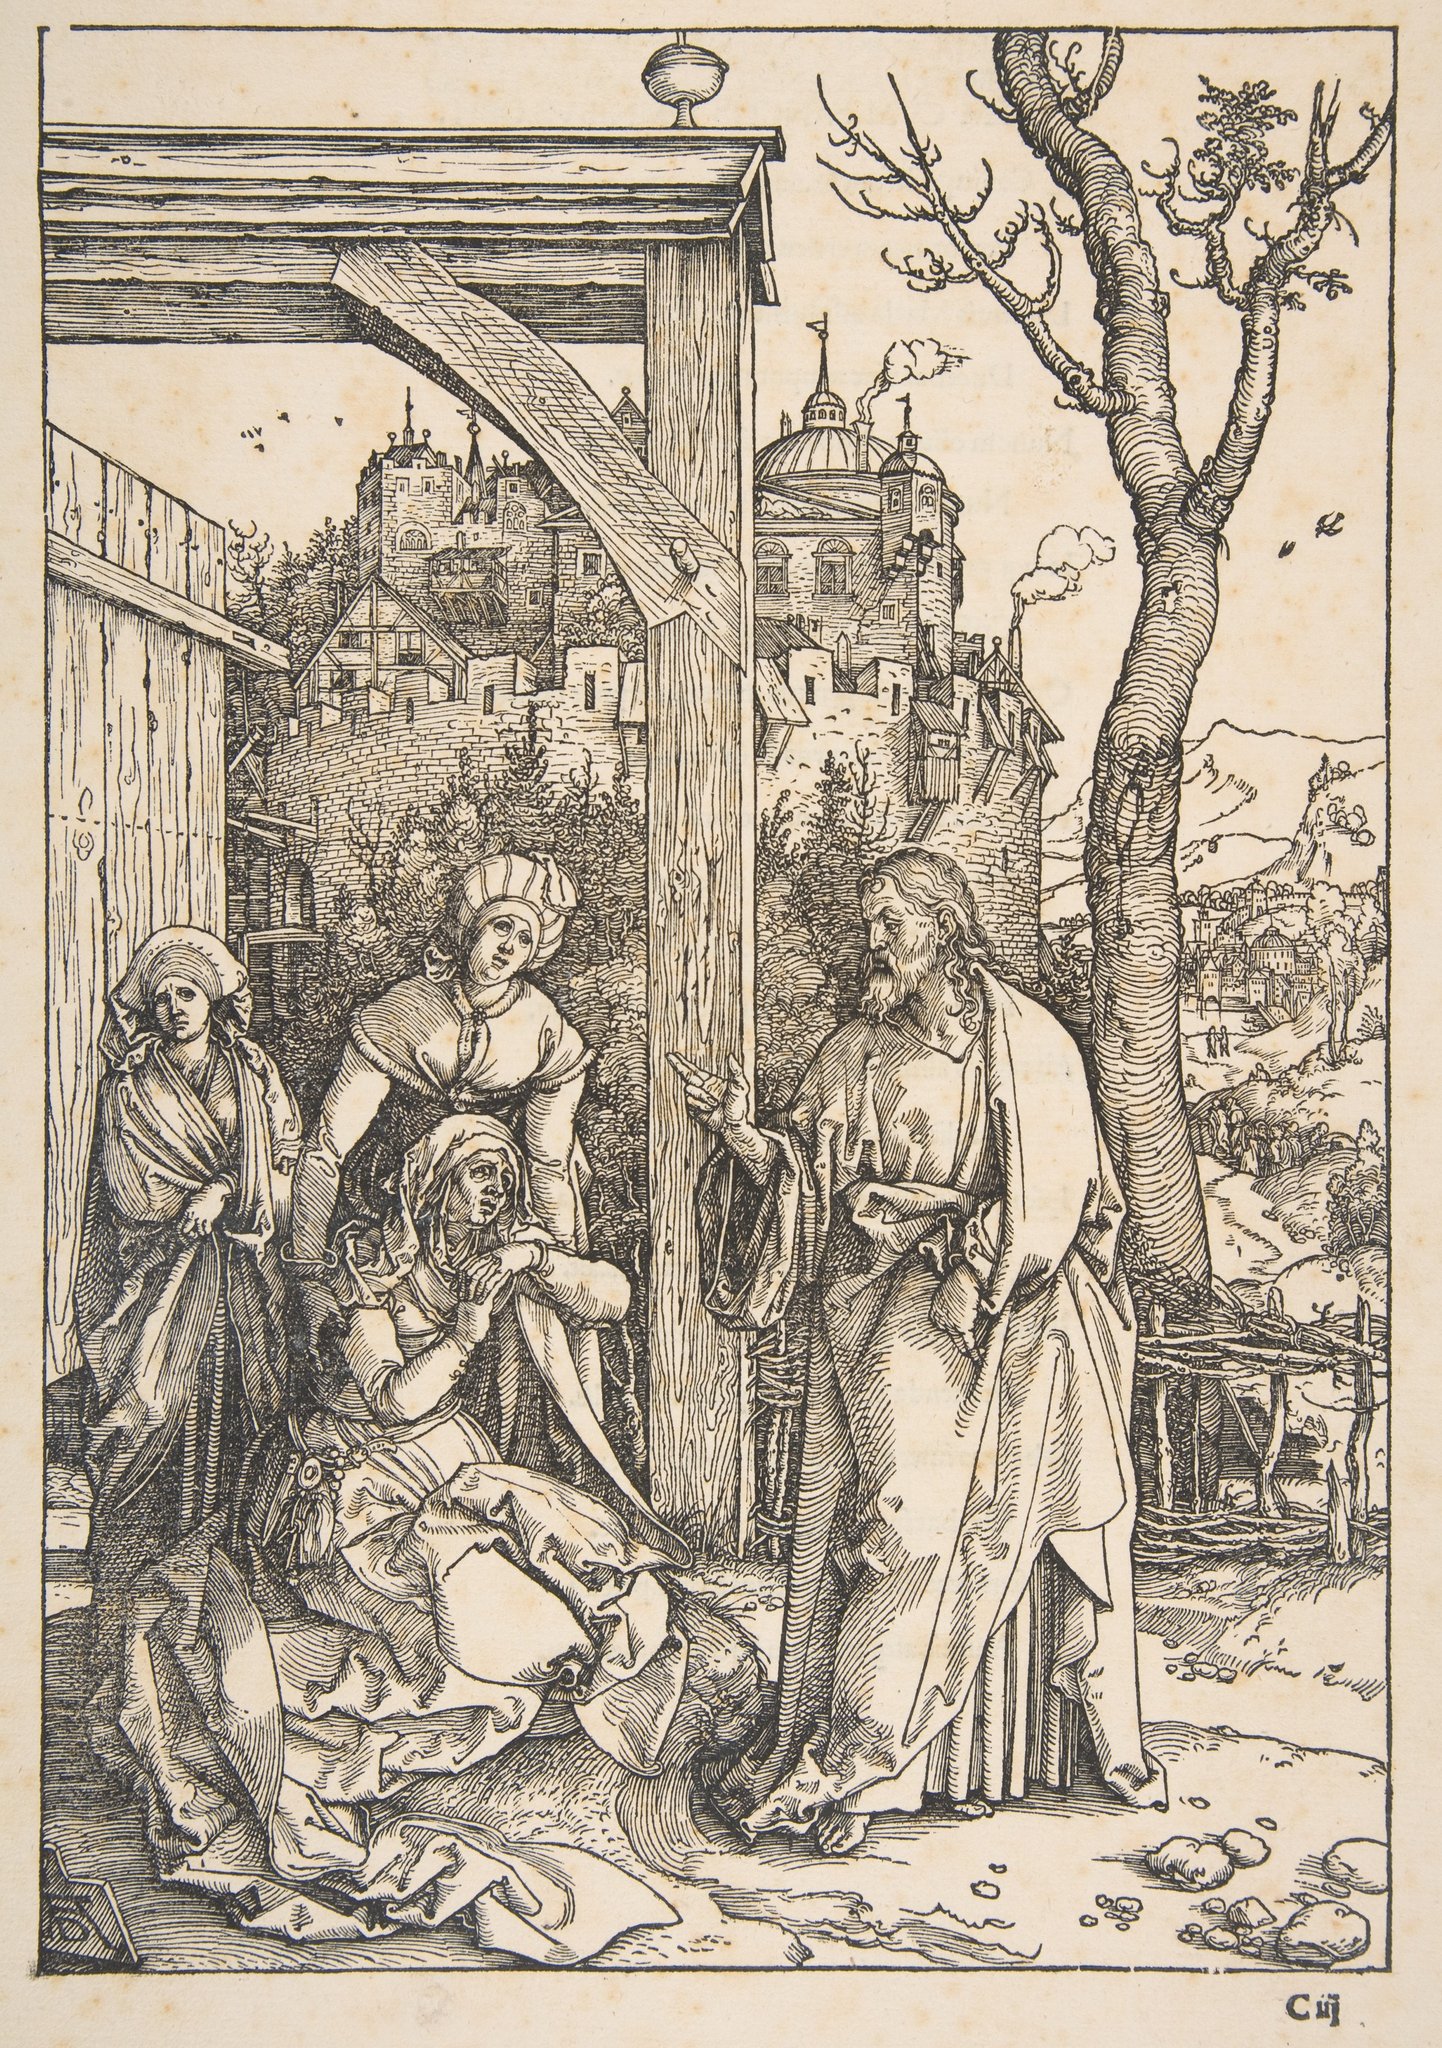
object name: print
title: Christ Taking Leave of His Mother, from "The Life of the Virgin"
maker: albrecht dürer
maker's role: artist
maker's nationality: german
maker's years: 1471-1528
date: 1511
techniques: woodcut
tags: women,christ,virgin mary